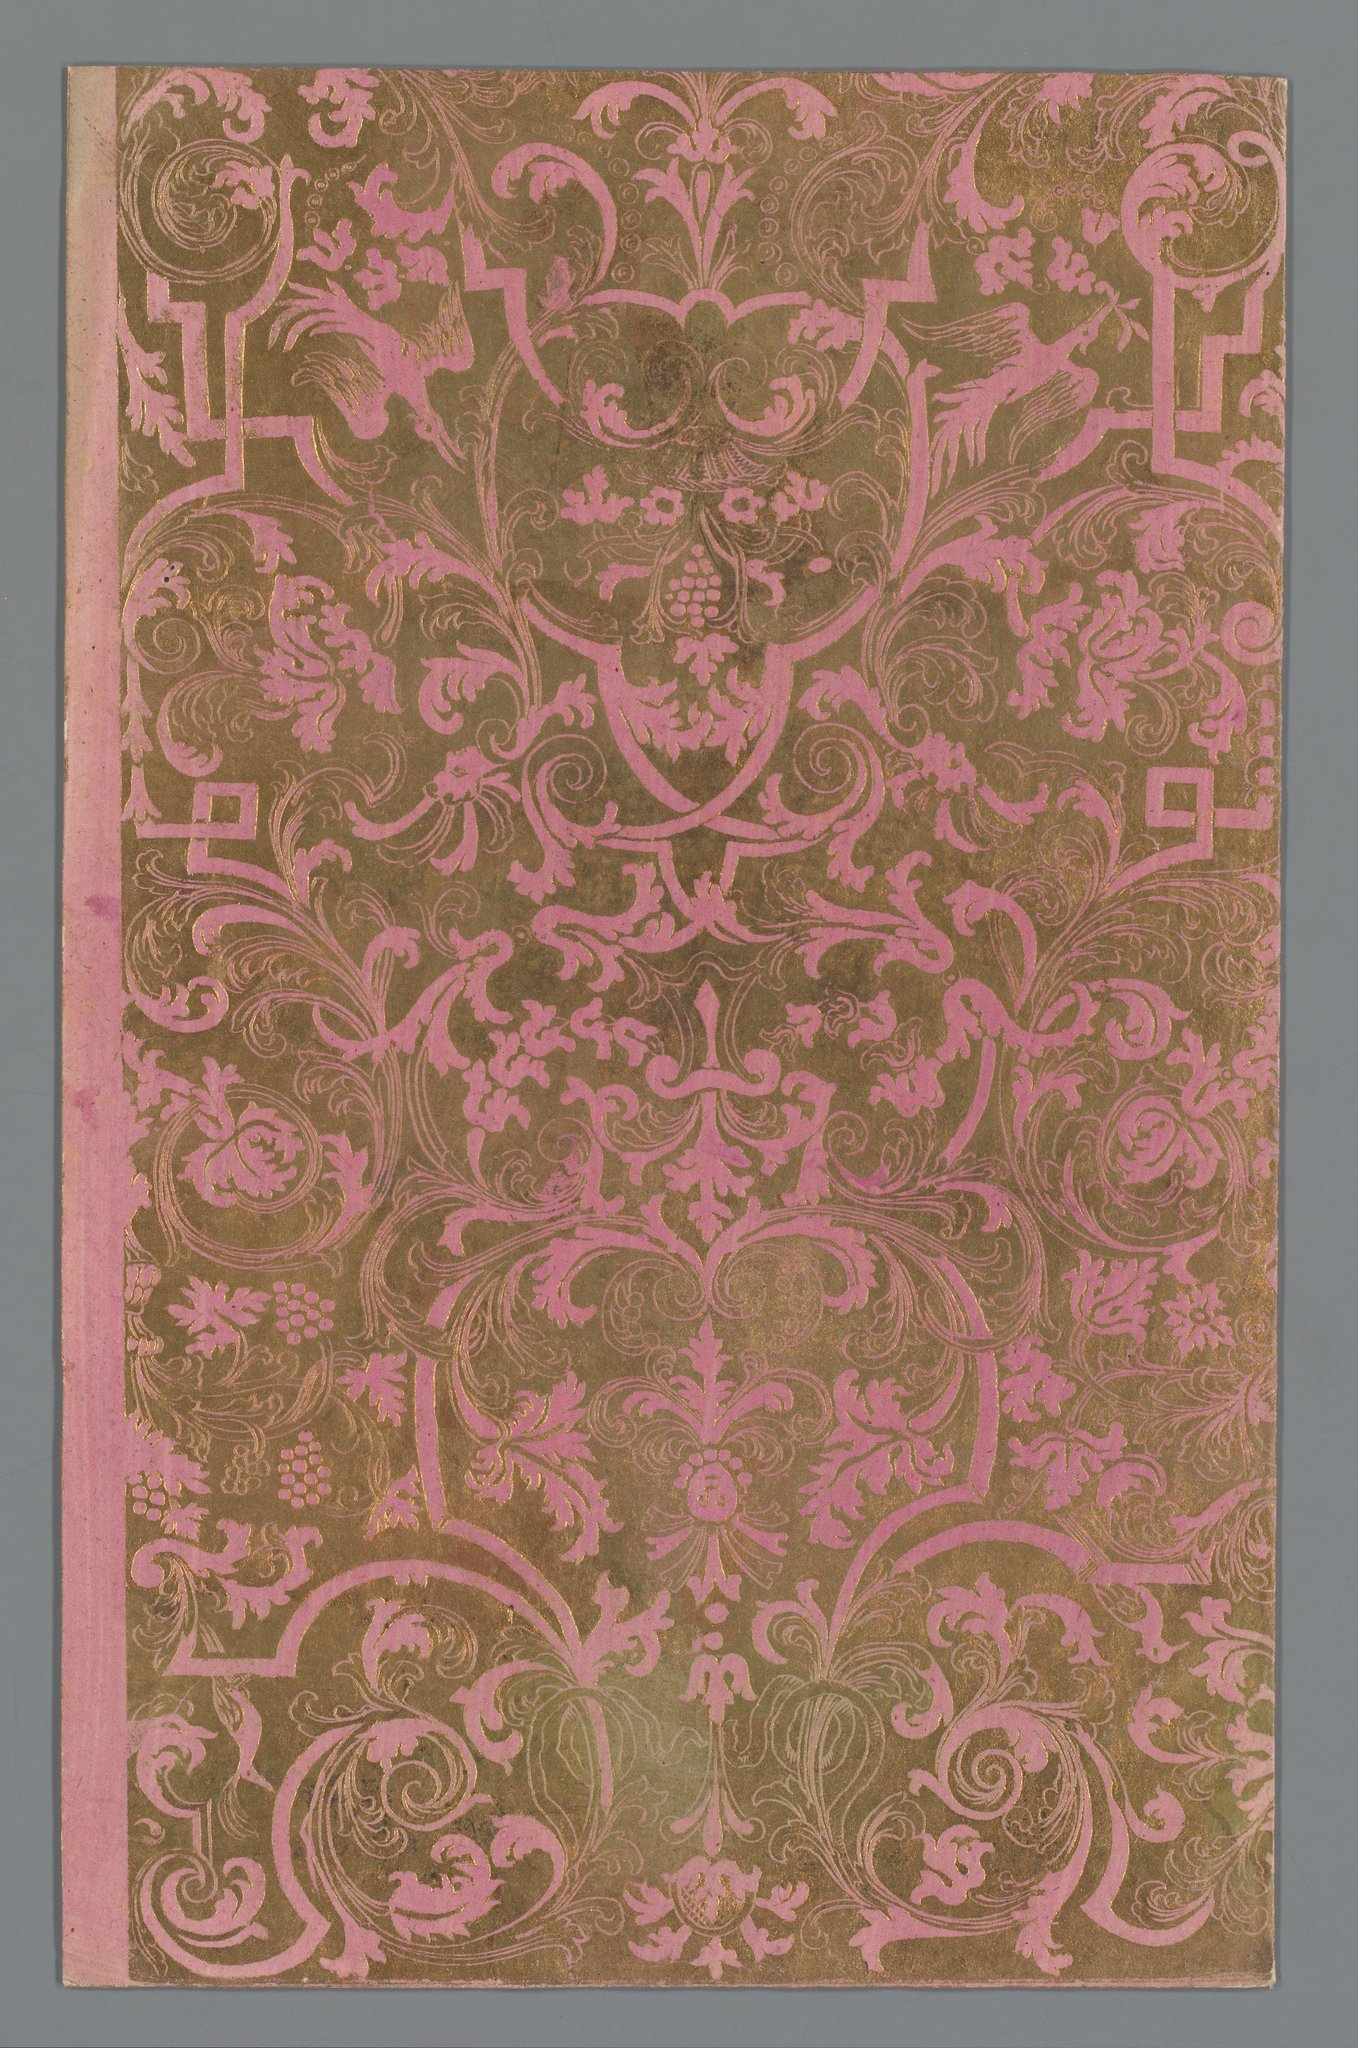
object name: brocade paper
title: Boekje met omslag van brokaatpapier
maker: Anonymous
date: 1720-1730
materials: gold leaf, paint, paper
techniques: relief print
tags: ornament derived from animal forms, ornament derived from plant forms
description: Pamflet met een omslag van een blad brokaatpapier met gestileerde ranken met bloemen en vruchten en vogels. Het pamflet bestaat uit drie bladen en is waarschijnlijk gedrukt in Würzburg in 1726.